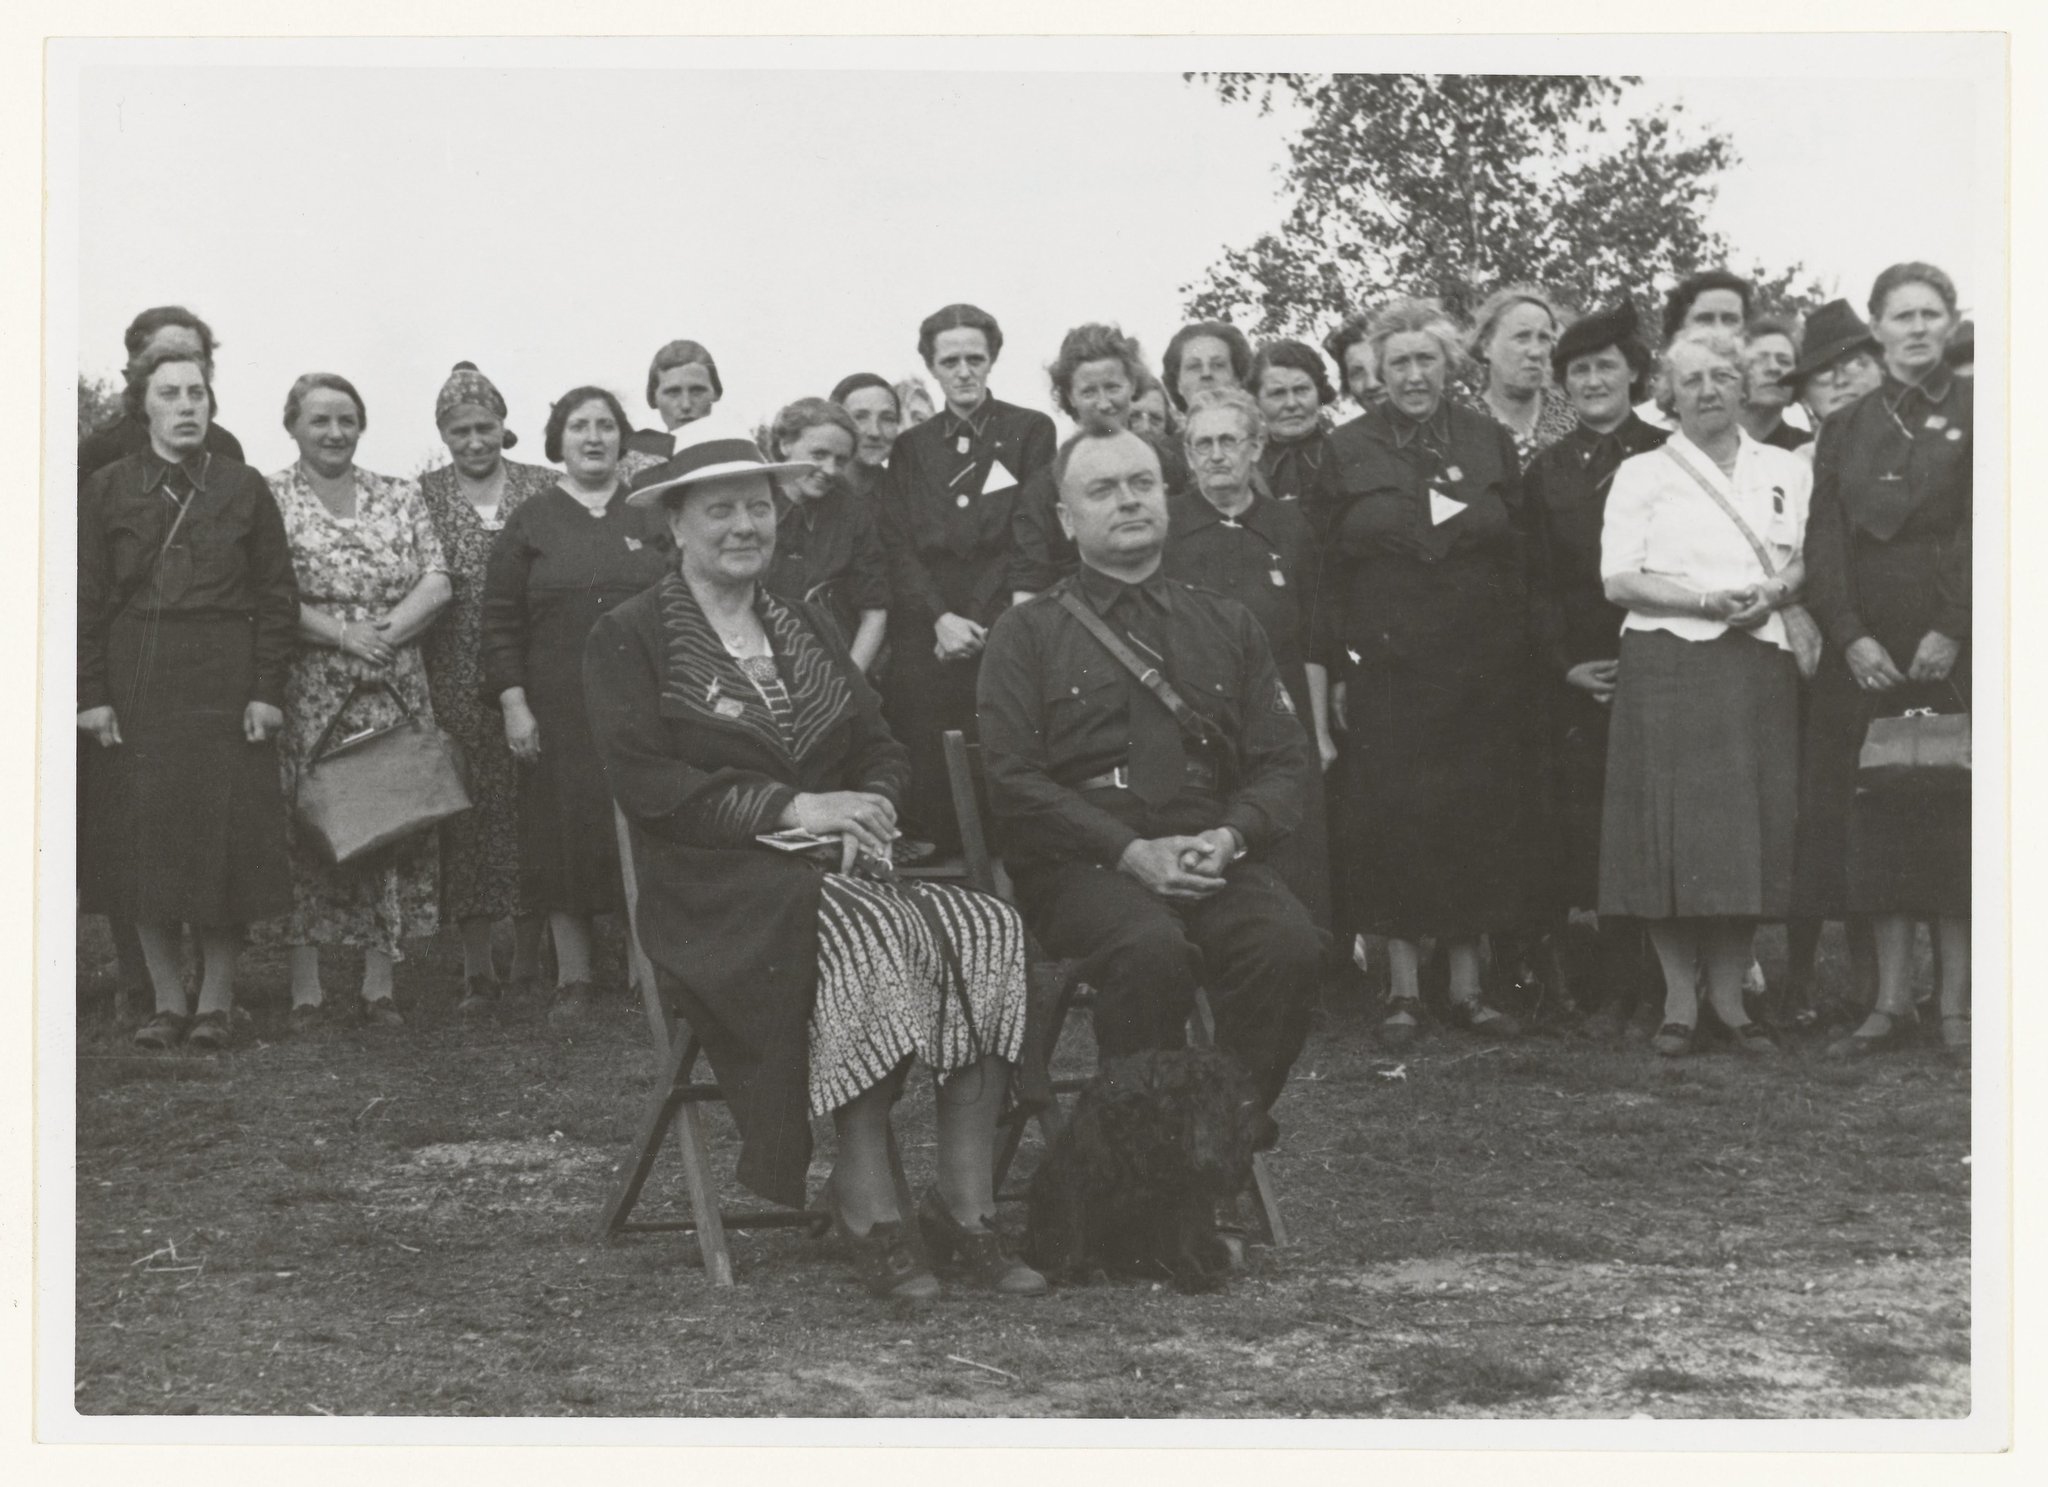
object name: photograph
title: NSB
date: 1940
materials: photographic support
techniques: photography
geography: lunteren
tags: the hague, politician, anton adriaan mussert, enkhuizen, military celebrations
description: Mussert en zijn vrouw tijdens een Hagespraak in Lunteren op 22 juni 1940. Achter hen luisterende vrouwen. Mussert trouwde in 1917 zijn tante, de 18 jaar oudere zuster van zijn moeder, Maria Witlam.